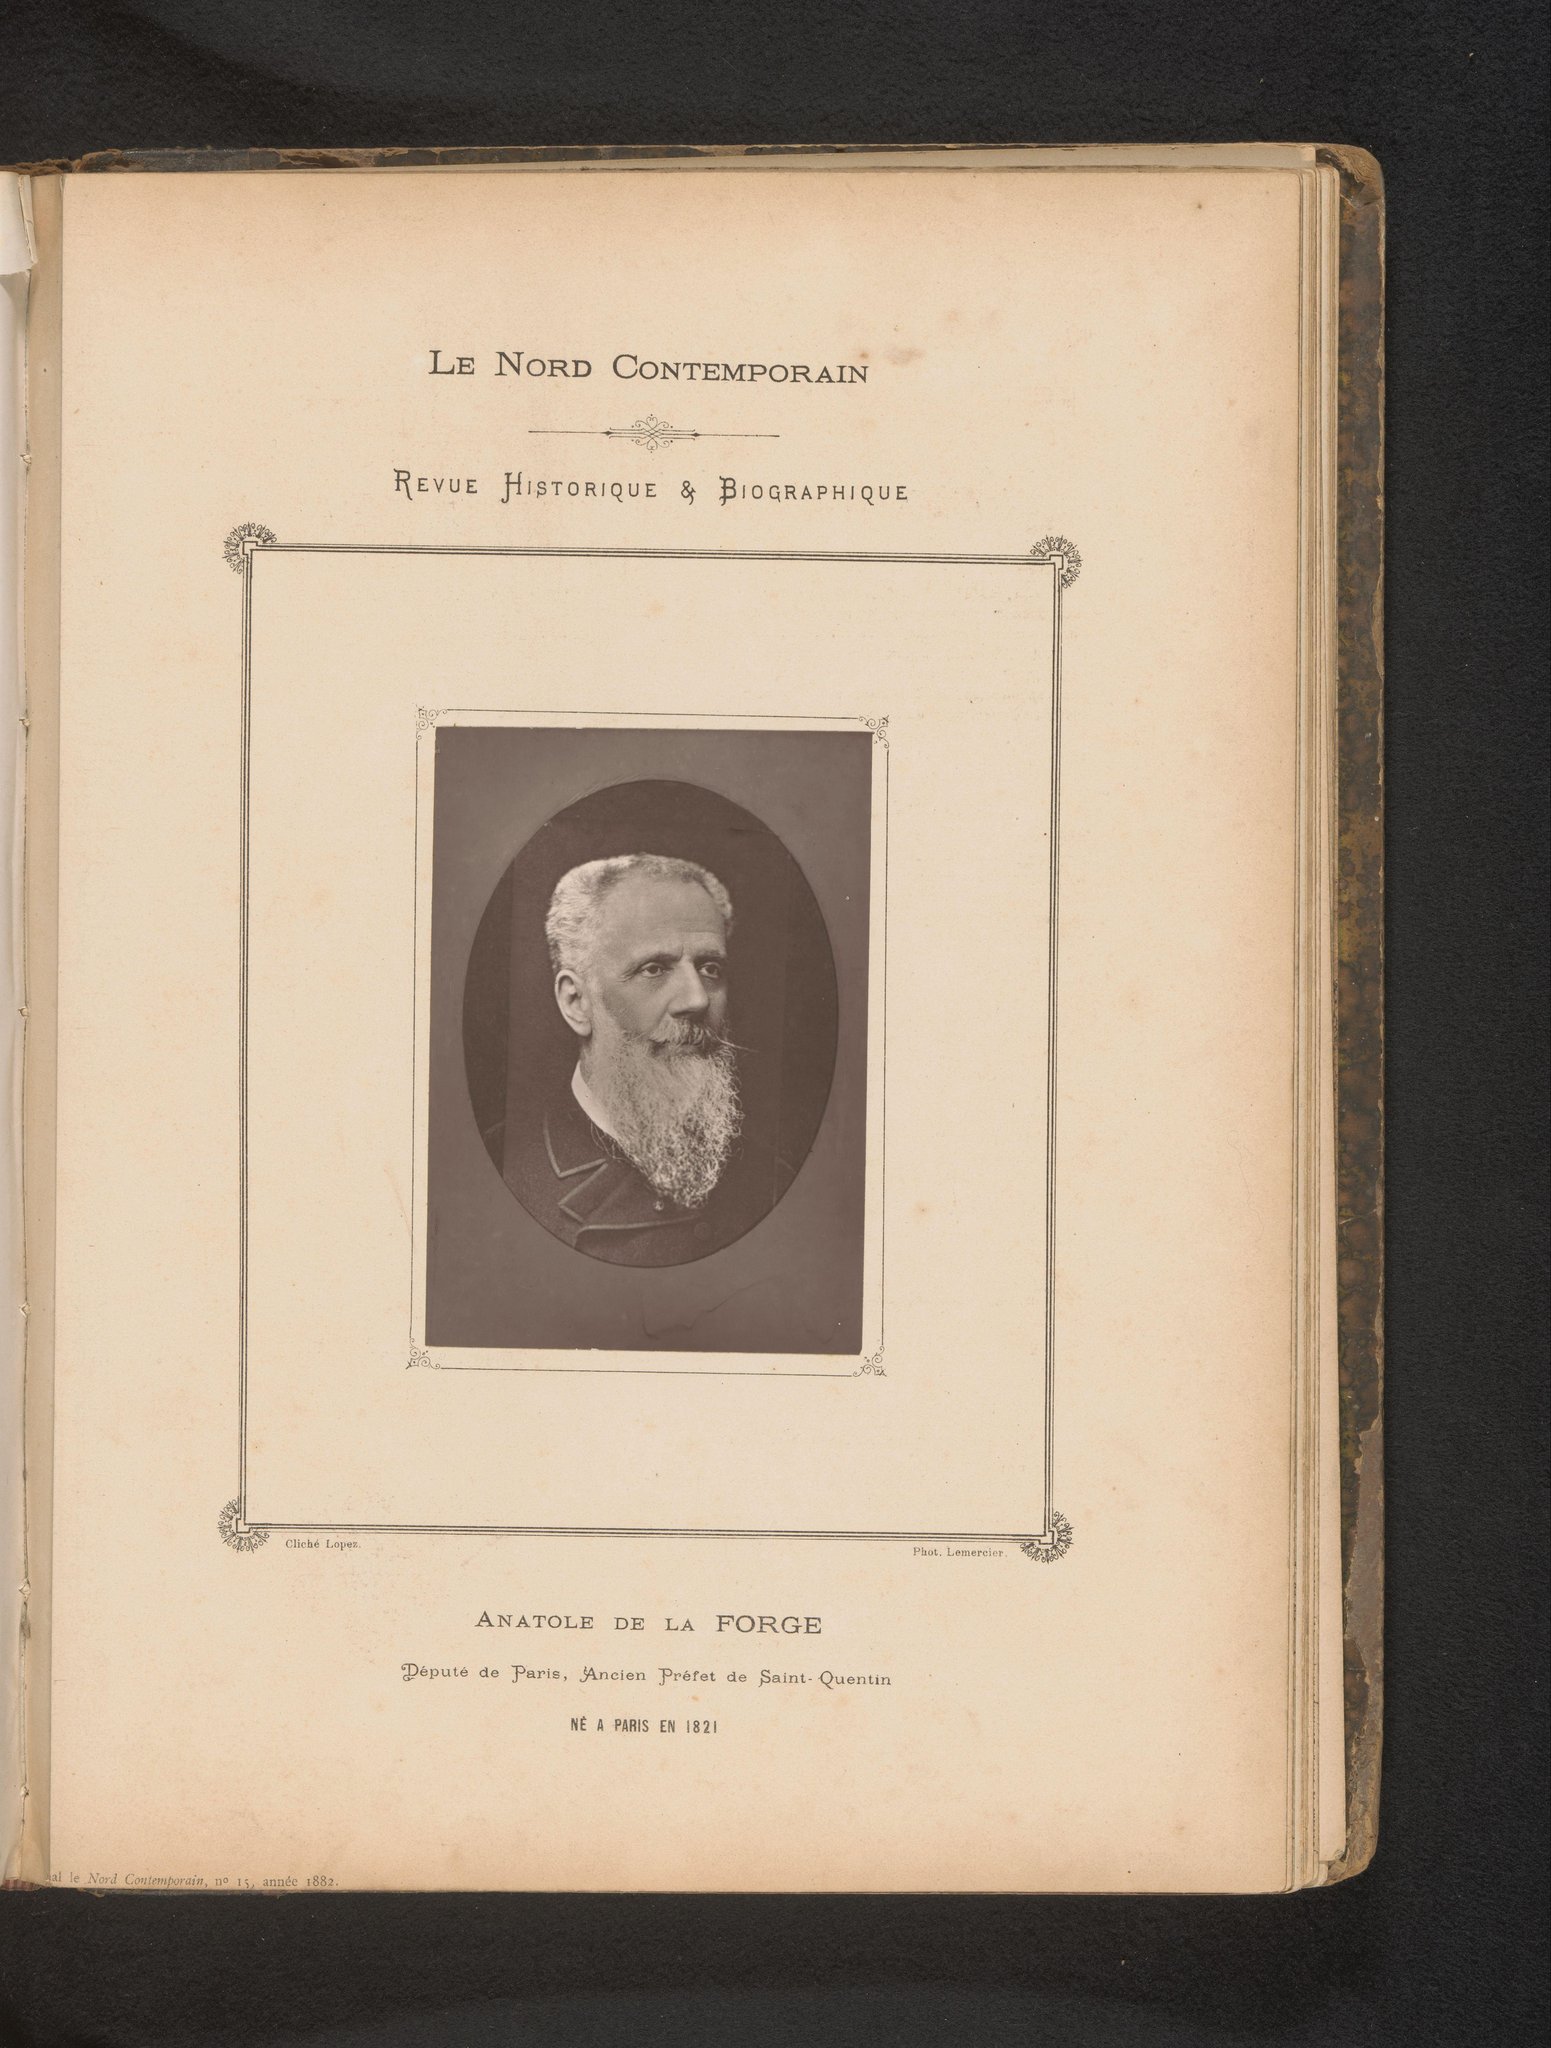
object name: photomechanical print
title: Grafmonument van Jean-Baptiste Carpeaux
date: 1878-1882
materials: paper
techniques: woodburytype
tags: historical persons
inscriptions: inscription: ‘Député de Paris, Ancien Préfet de Saint-Quentin/ Né a Paris en 1821’, inscription: ‘Journal le Nord Contemporain, No 15, année 1882’, inscription: ‘Le Nord Contemporain/ Revue Artistique & Archéologique’